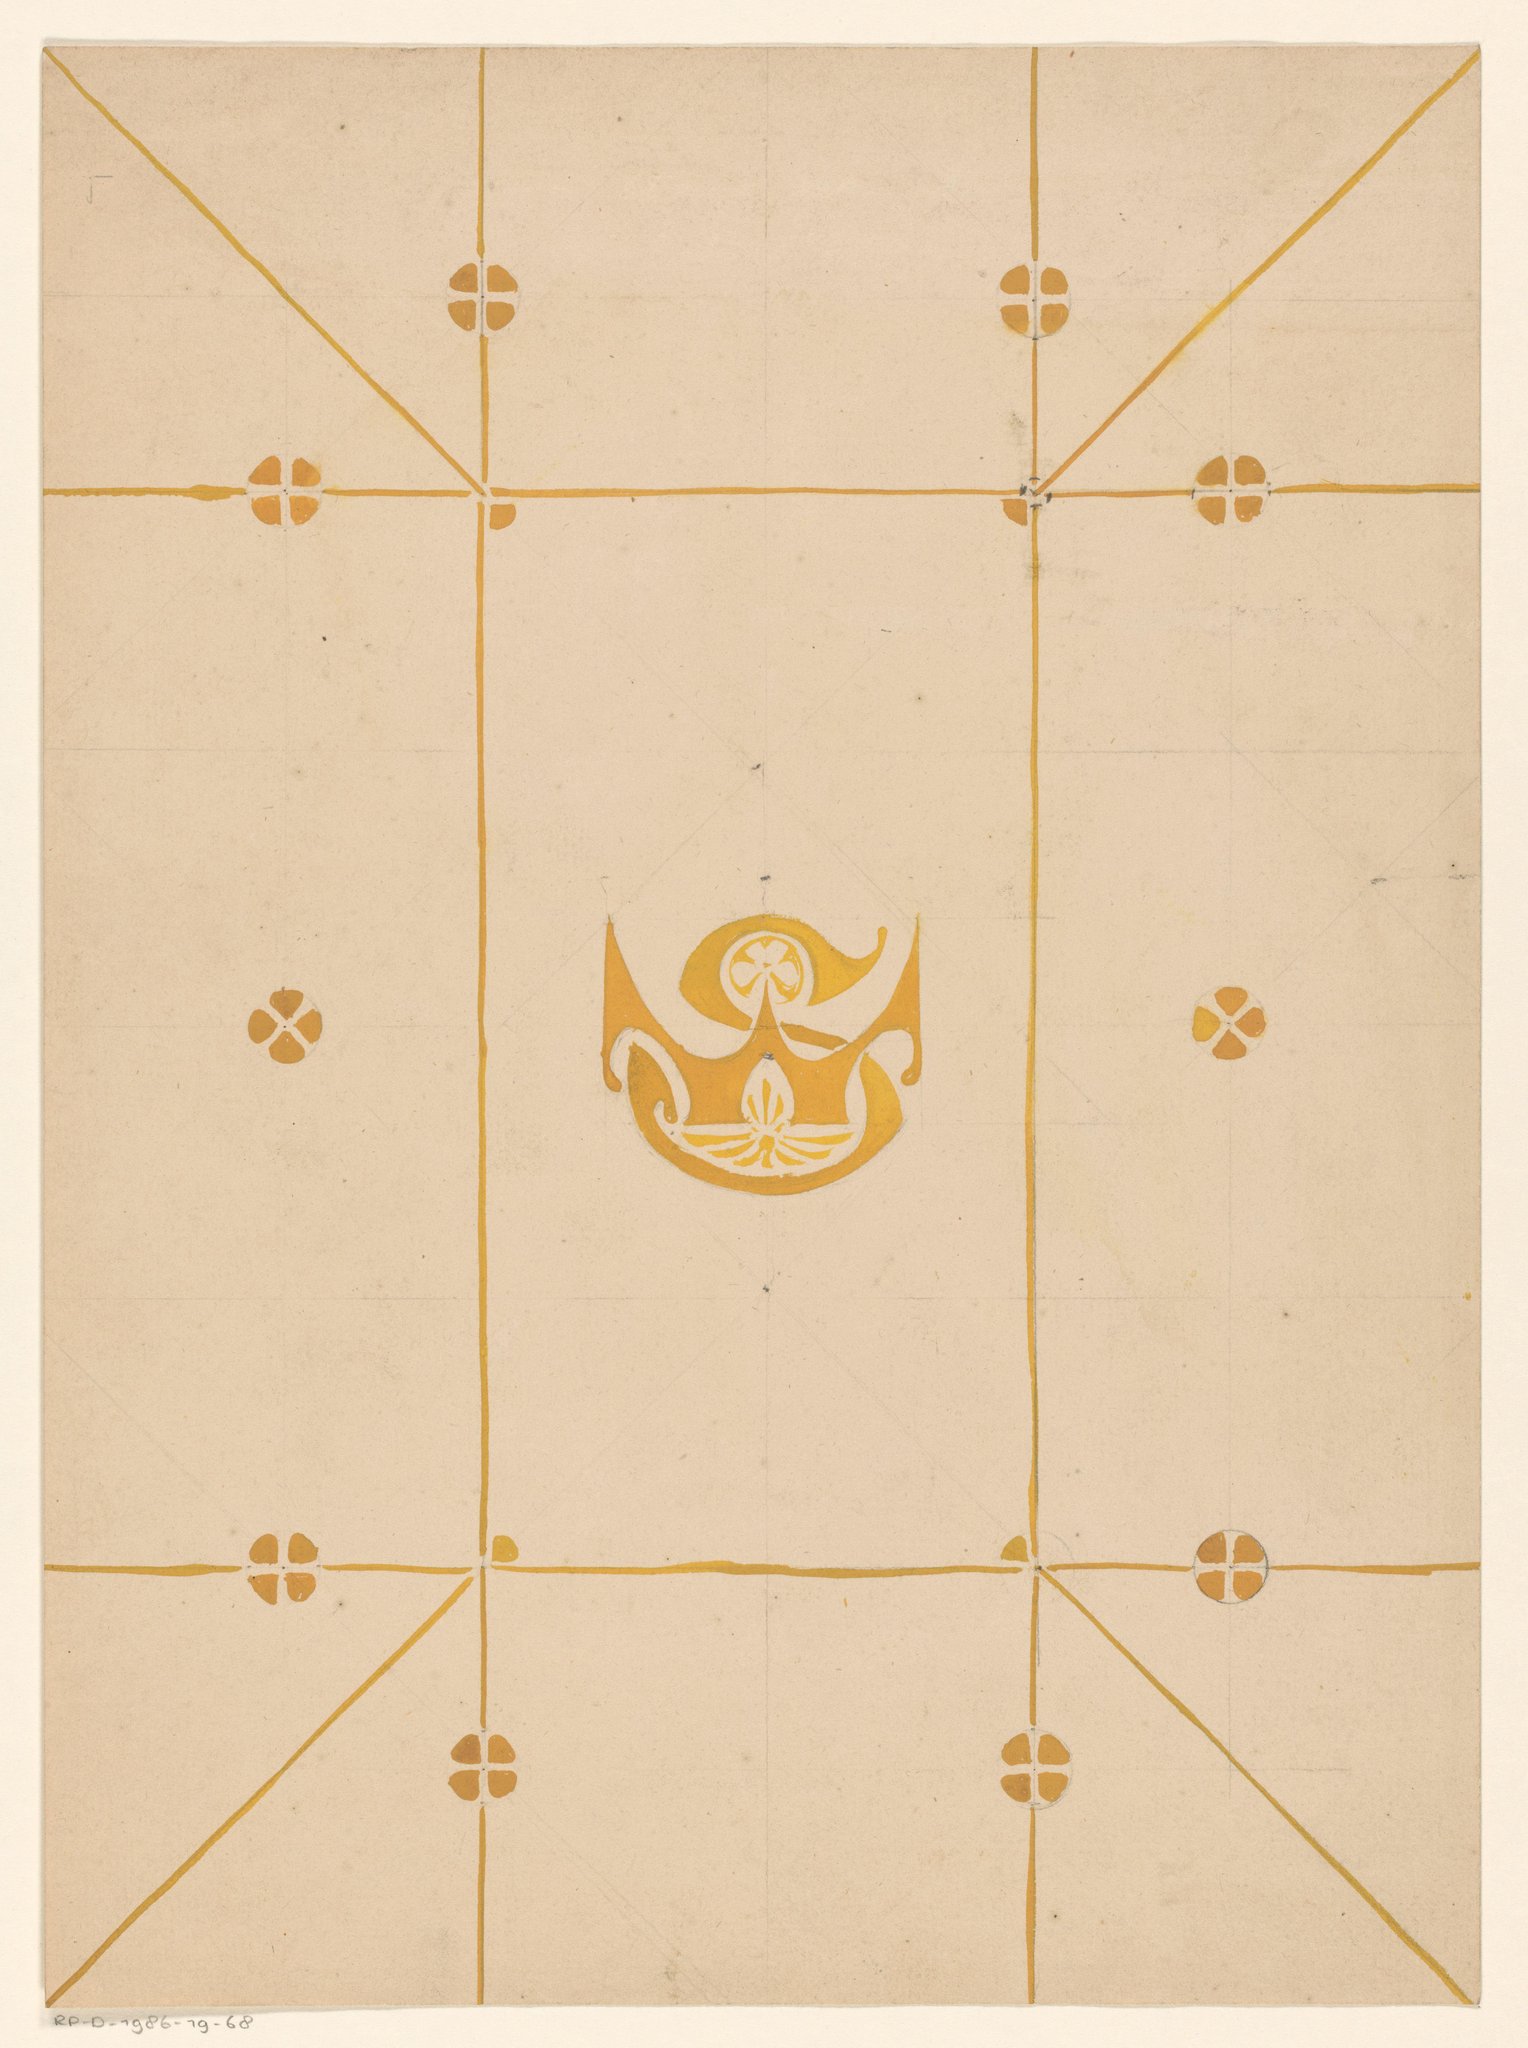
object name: study for binding design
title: Bandontwerp voor een album voor Prof. Willem Stoeder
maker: reinier willem petrus de vries (1874-1953)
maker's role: draughtsman, print maker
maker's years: 1874-1953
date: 1902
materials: paint, paper, pencil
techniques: brush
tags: magic mathematical figures; magic numbers, words, monograms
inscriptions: collector's mark: ‘R:MVS.’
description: Bandontwerp voor een album voor Prof. Willem Stoeder ter gelegenheid van diens afscheid als hoogleraar artsenijbereidkunde aan de Universiteit van Amsterdam.